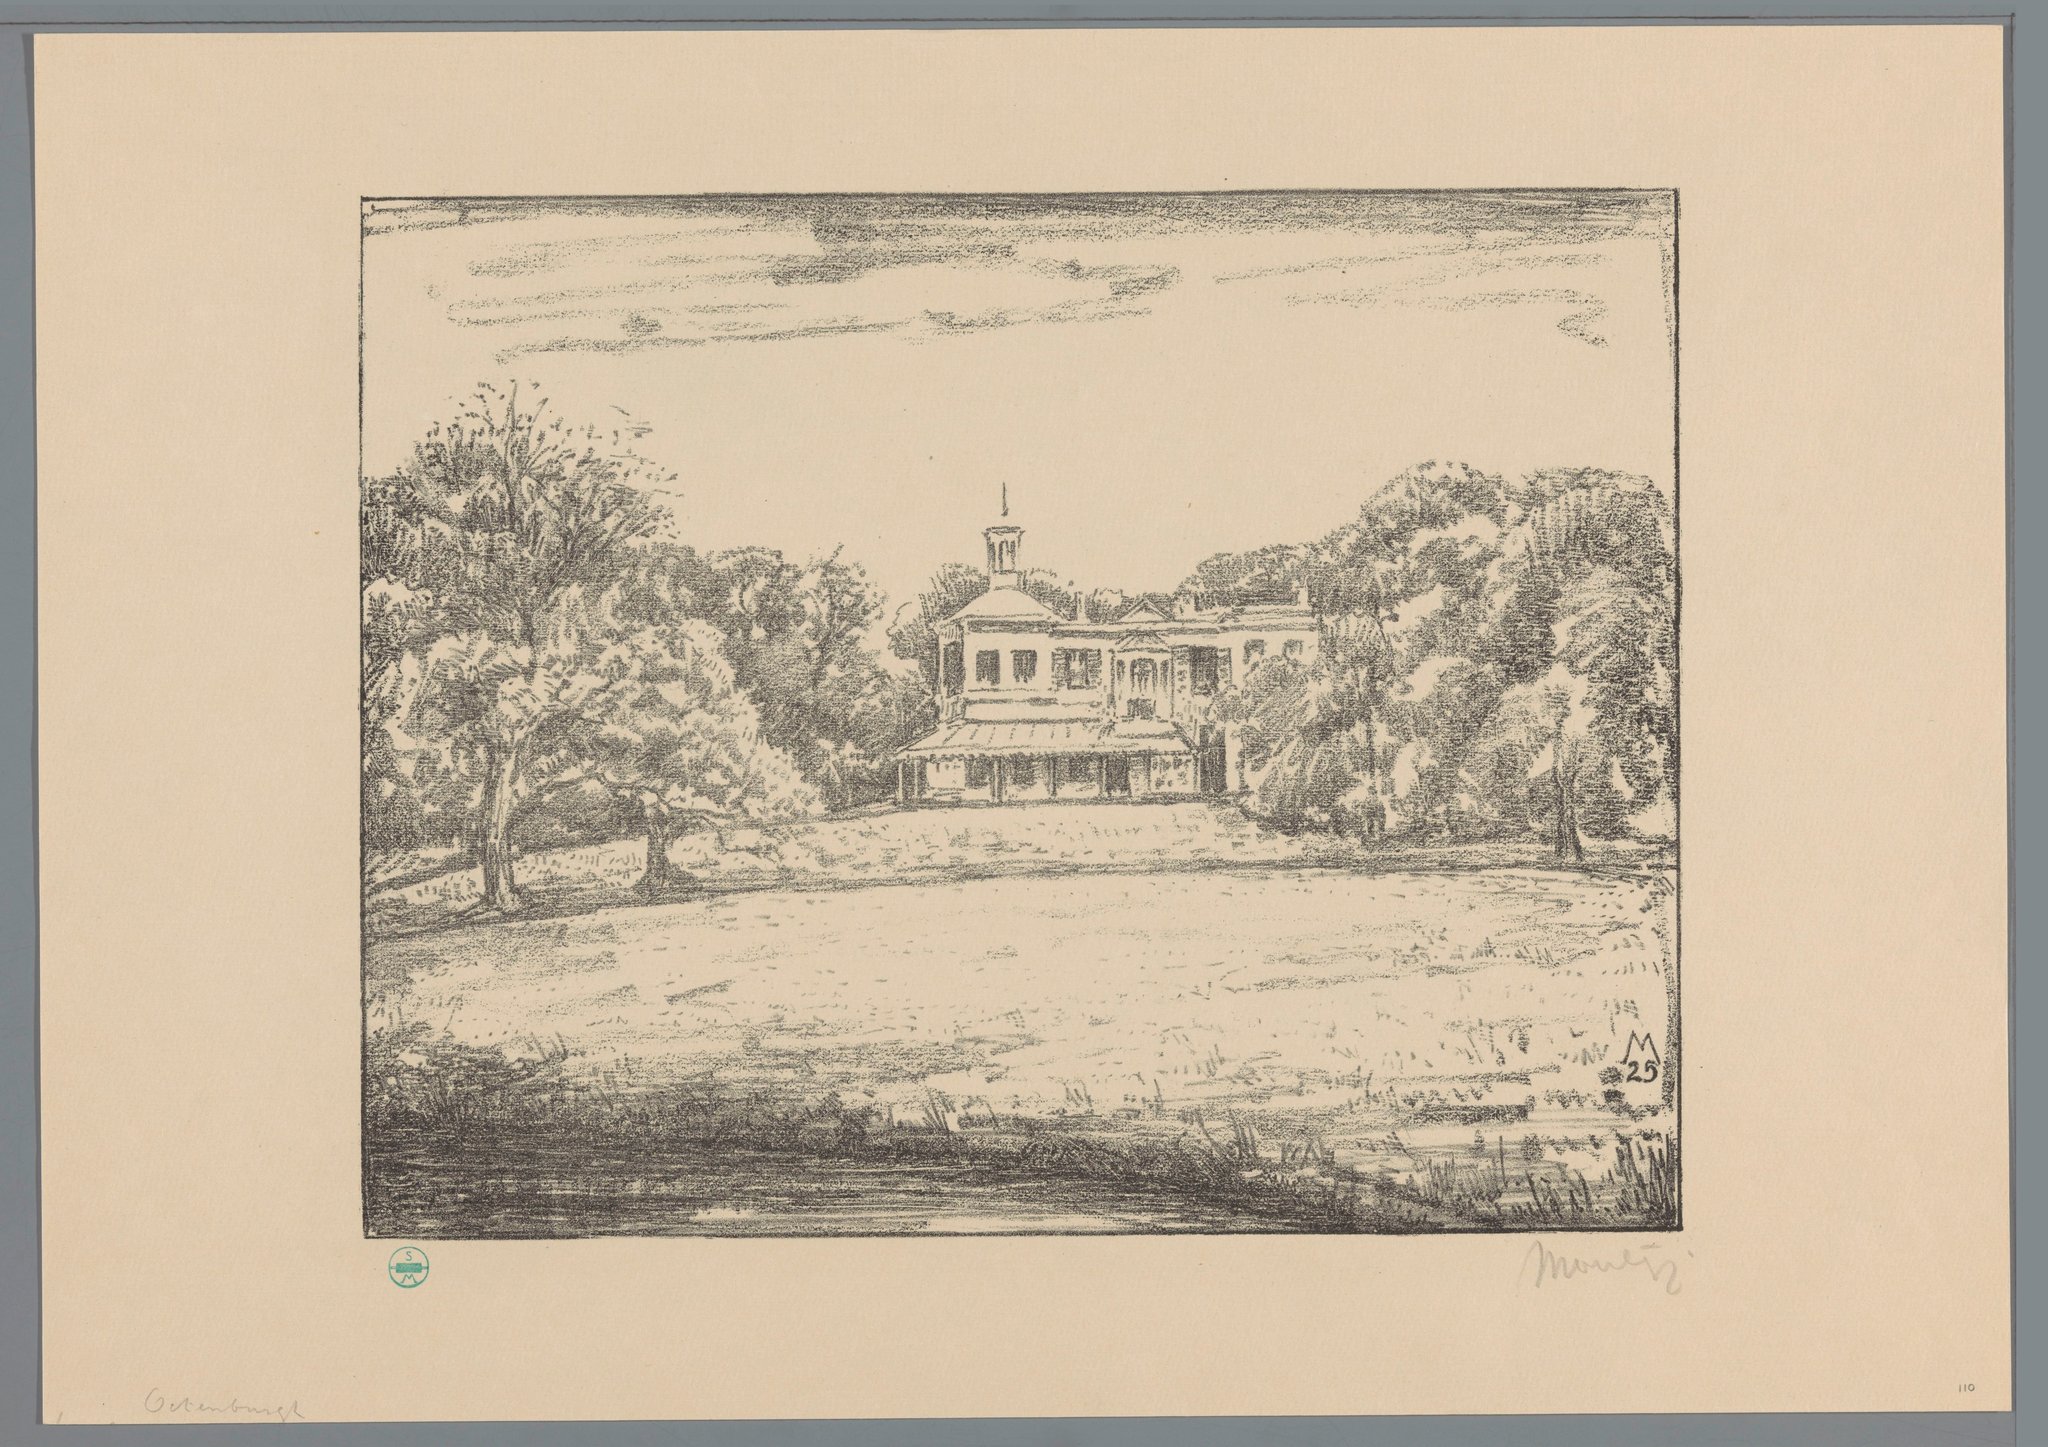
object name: print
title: Ockenburgh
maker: simon moulijn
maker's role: draughtsman, print maker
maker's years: 1866-1948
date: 1925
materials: paper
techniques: lithograph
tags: lawn, country-house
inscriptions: stamp: Lugt 2362b, collector's mark: Lugt 2228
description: Prent gebruikt voor: Moulijn, Simon en Gelder, Hendrik Enno van. Oude buitenplaatsen rondom 's-Gravenhage. 's-Gravenhage: Gemeentebestuur, 1929.